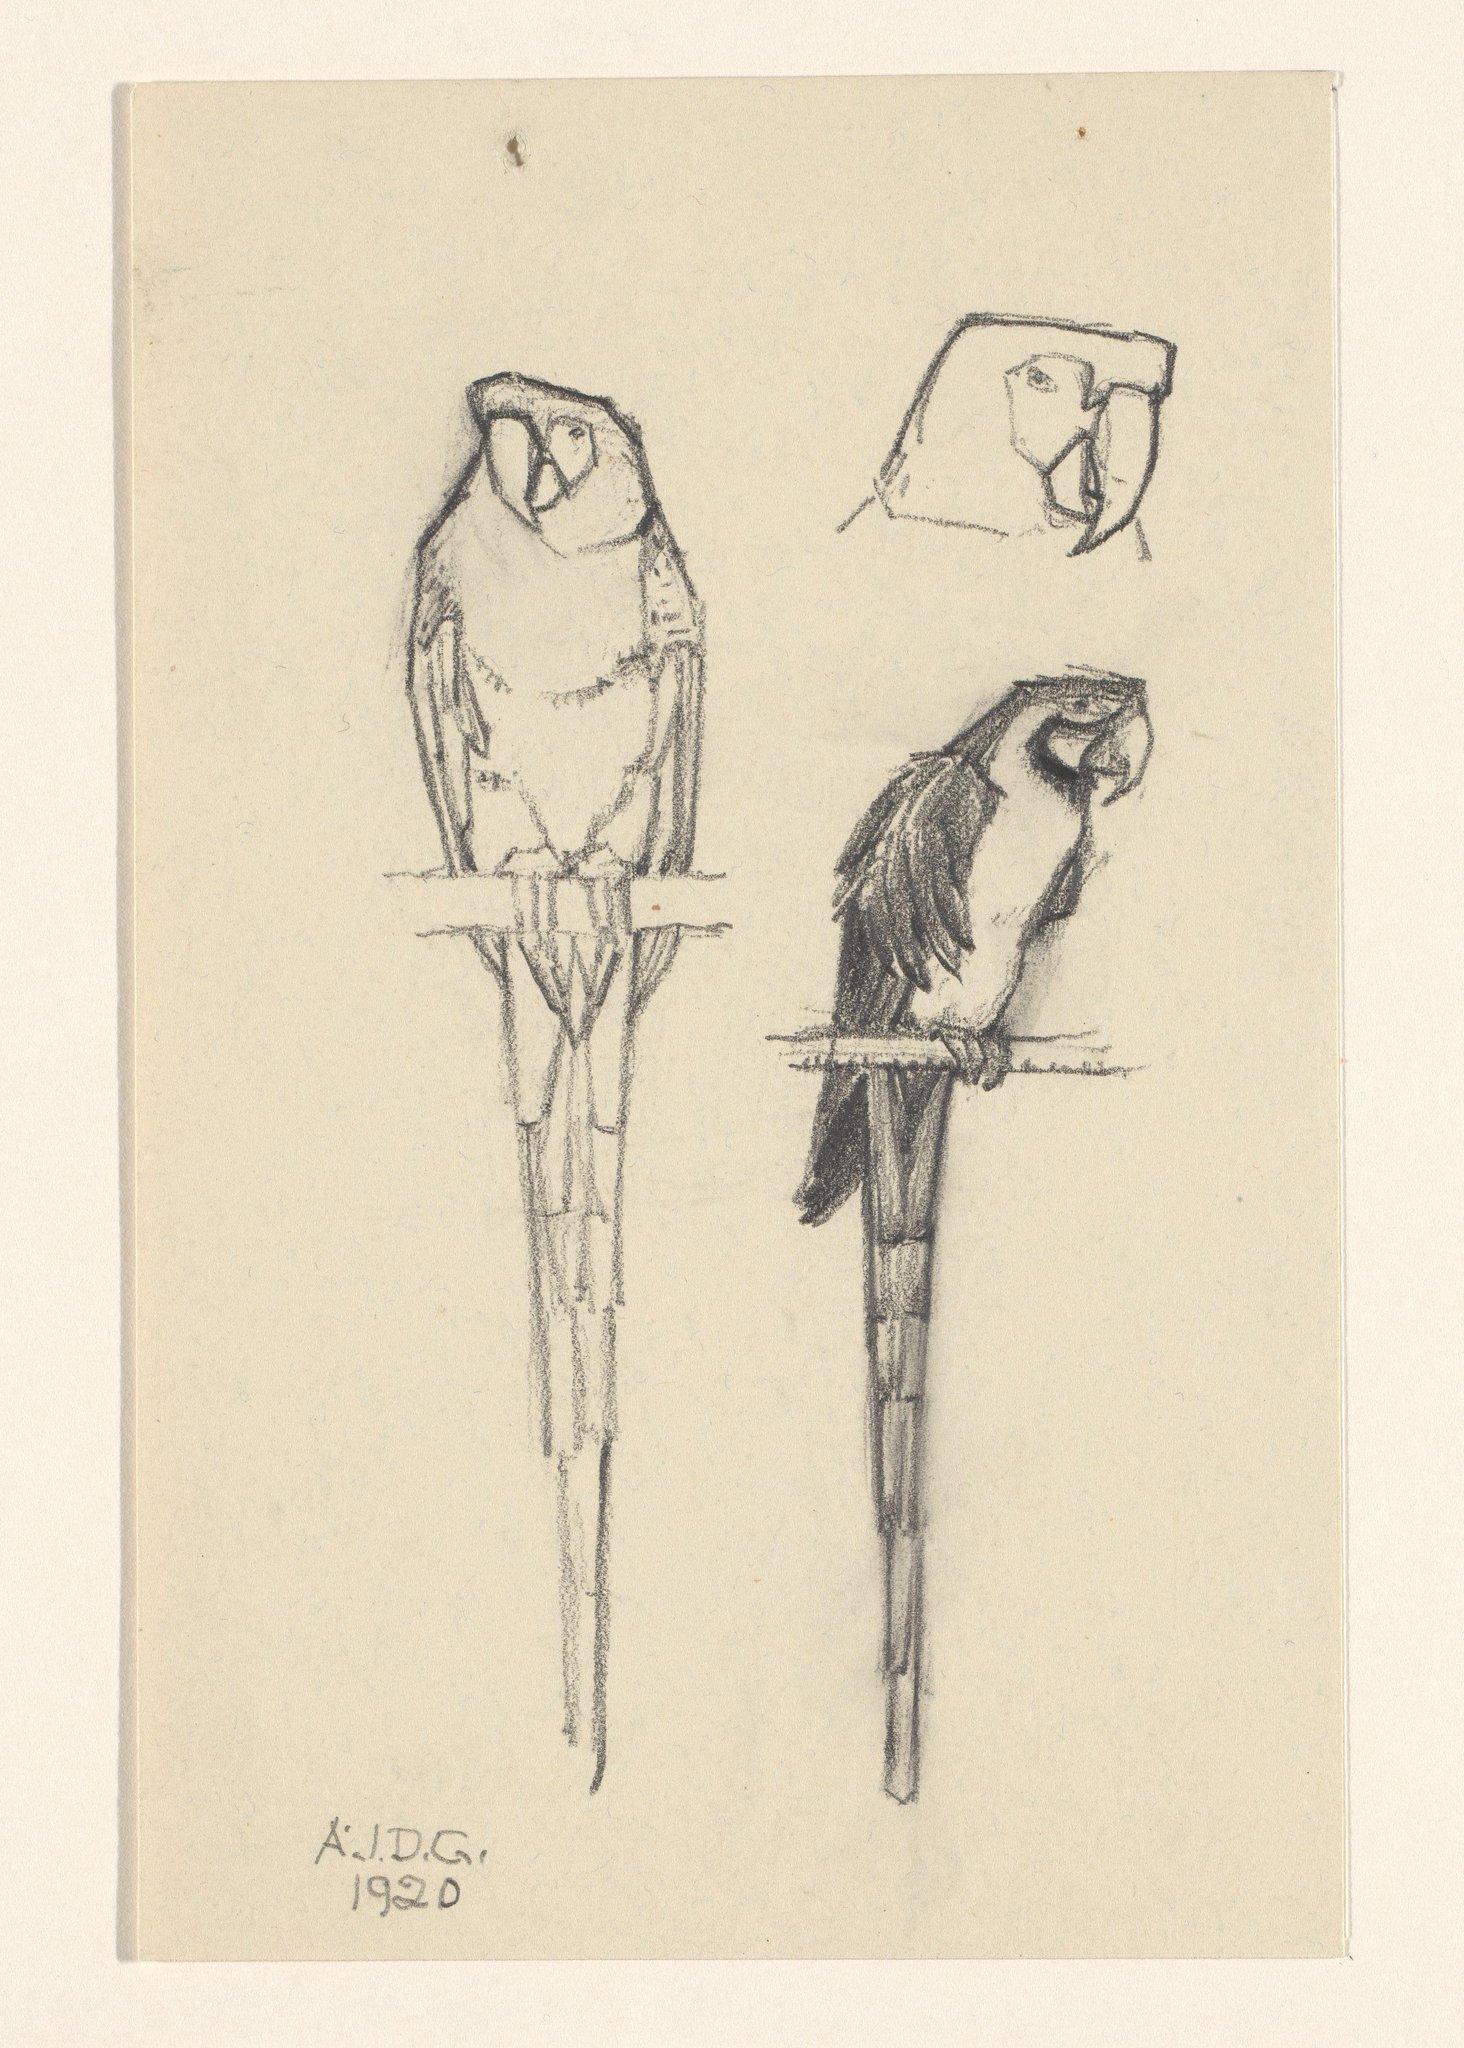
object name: drawing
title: Papegaaien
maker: julie de graag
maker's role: draughtsman, print maker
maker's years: 1877-1924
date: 1920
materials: paper, pencil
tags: ornamental birds: parrot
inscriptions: number: ‘53’, annotation: ‘1/4 g’